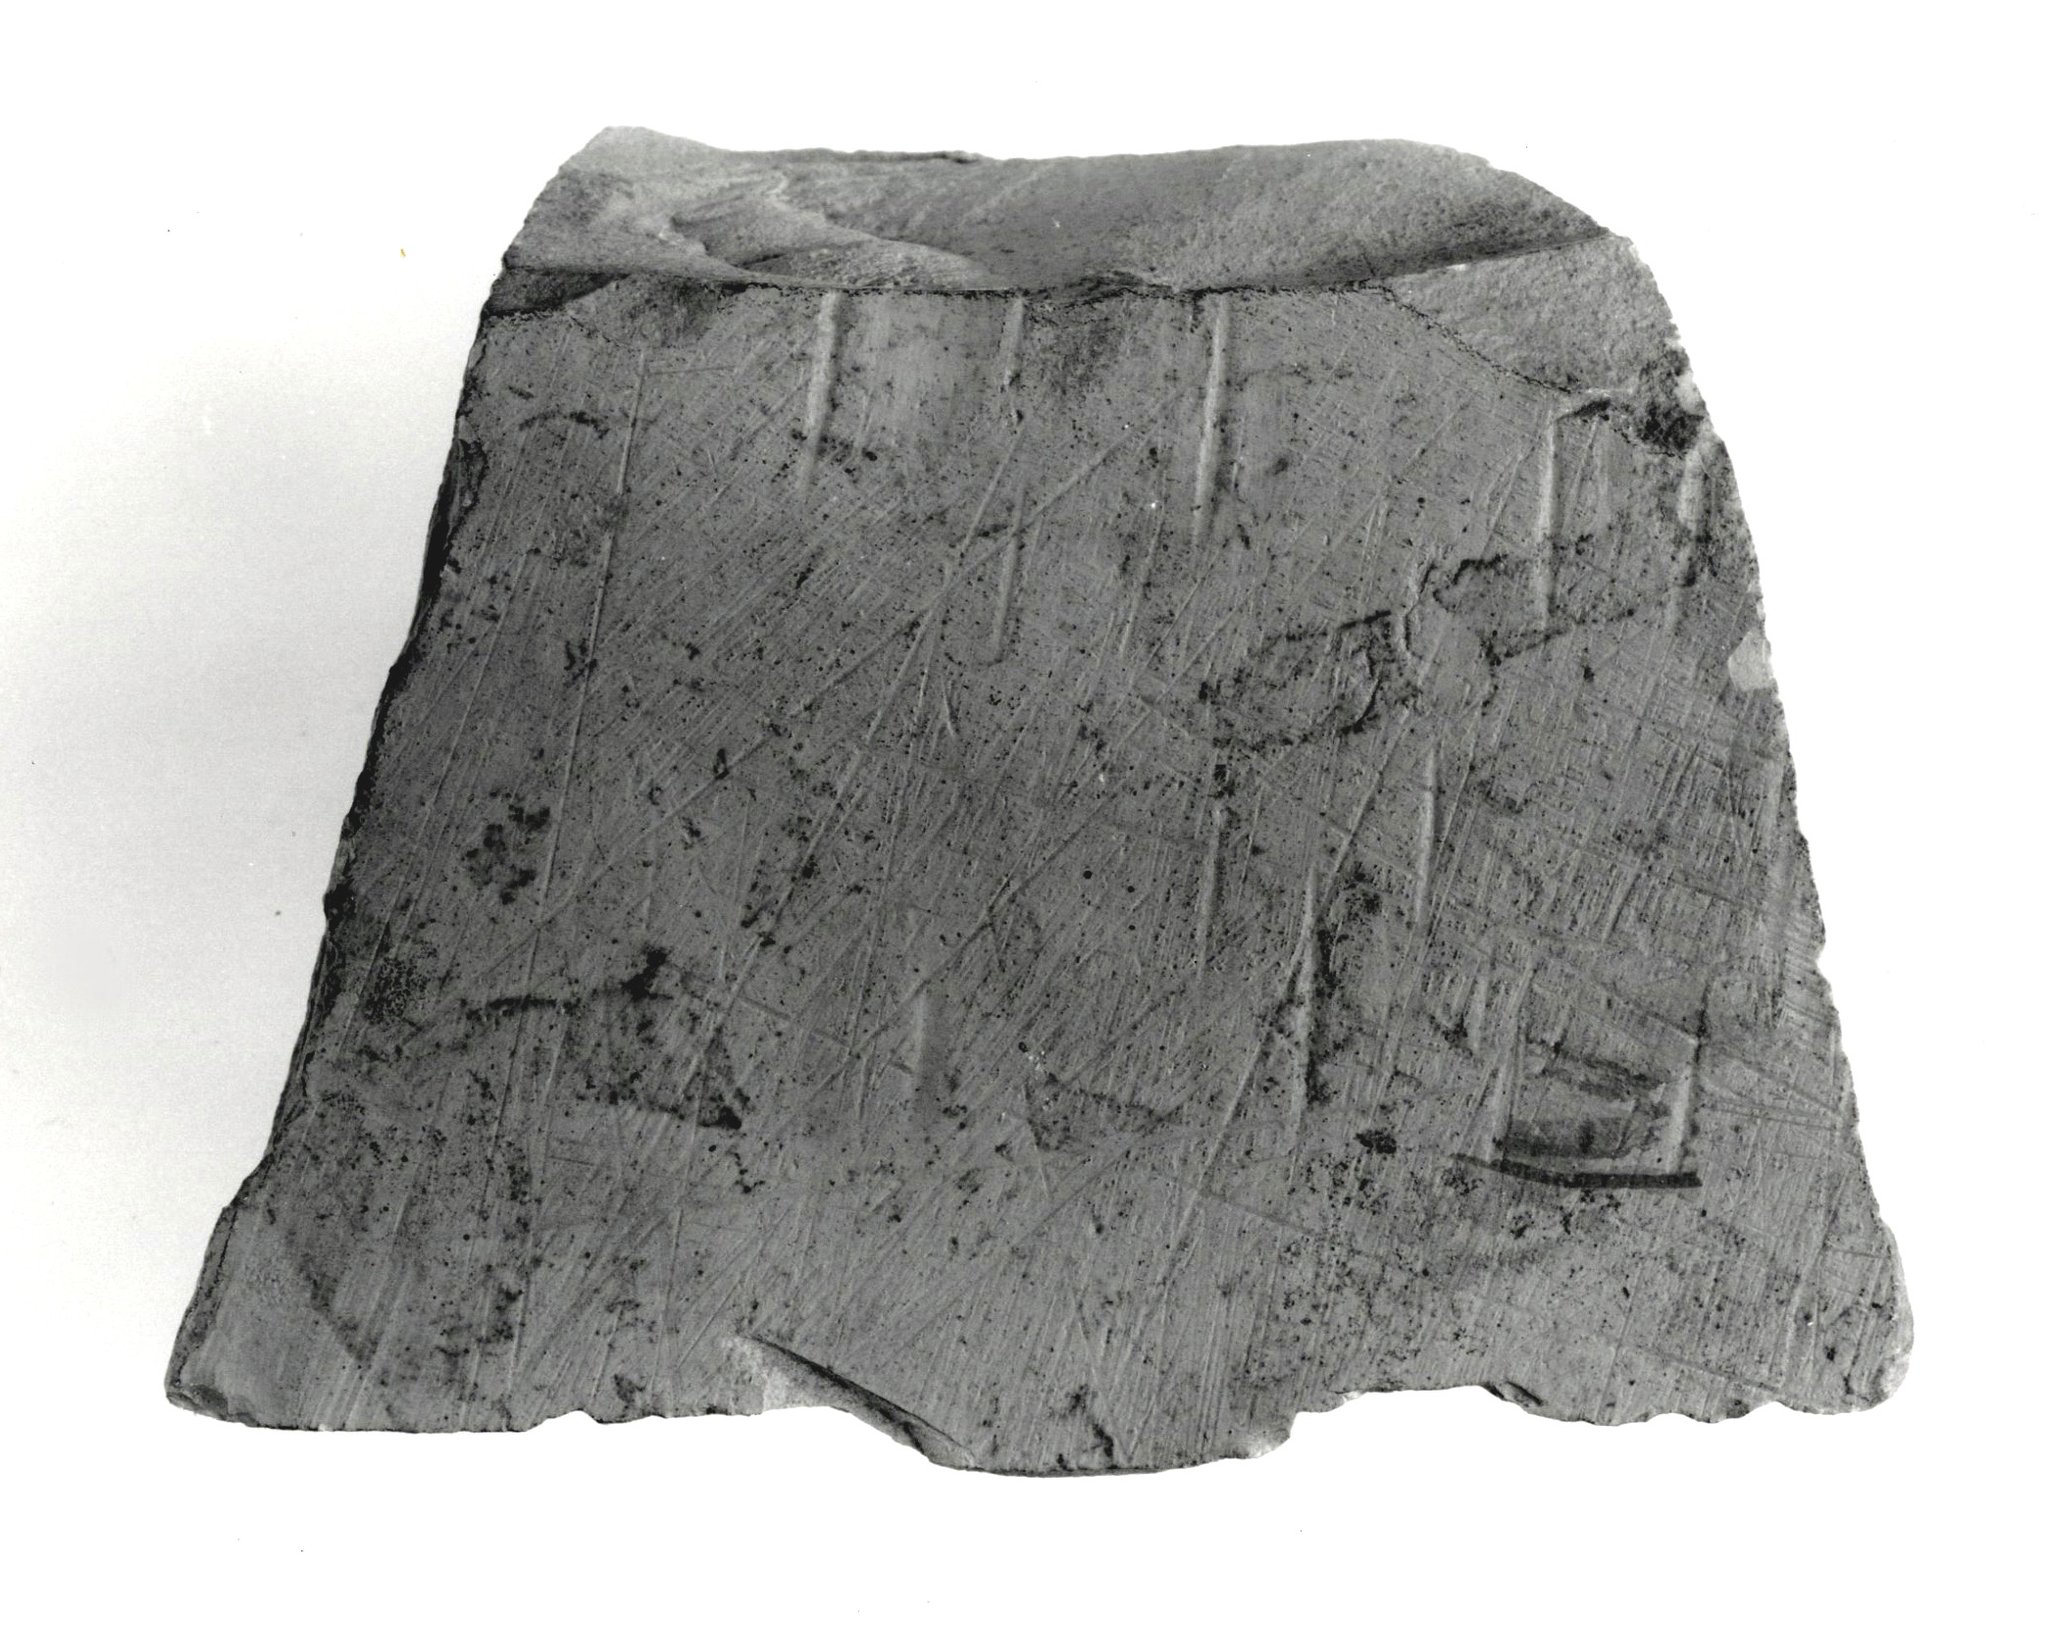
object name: relief, tomb of nespekashuty, wall casing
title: Wall casing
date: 664-610 BCE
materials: limestone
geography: egypt